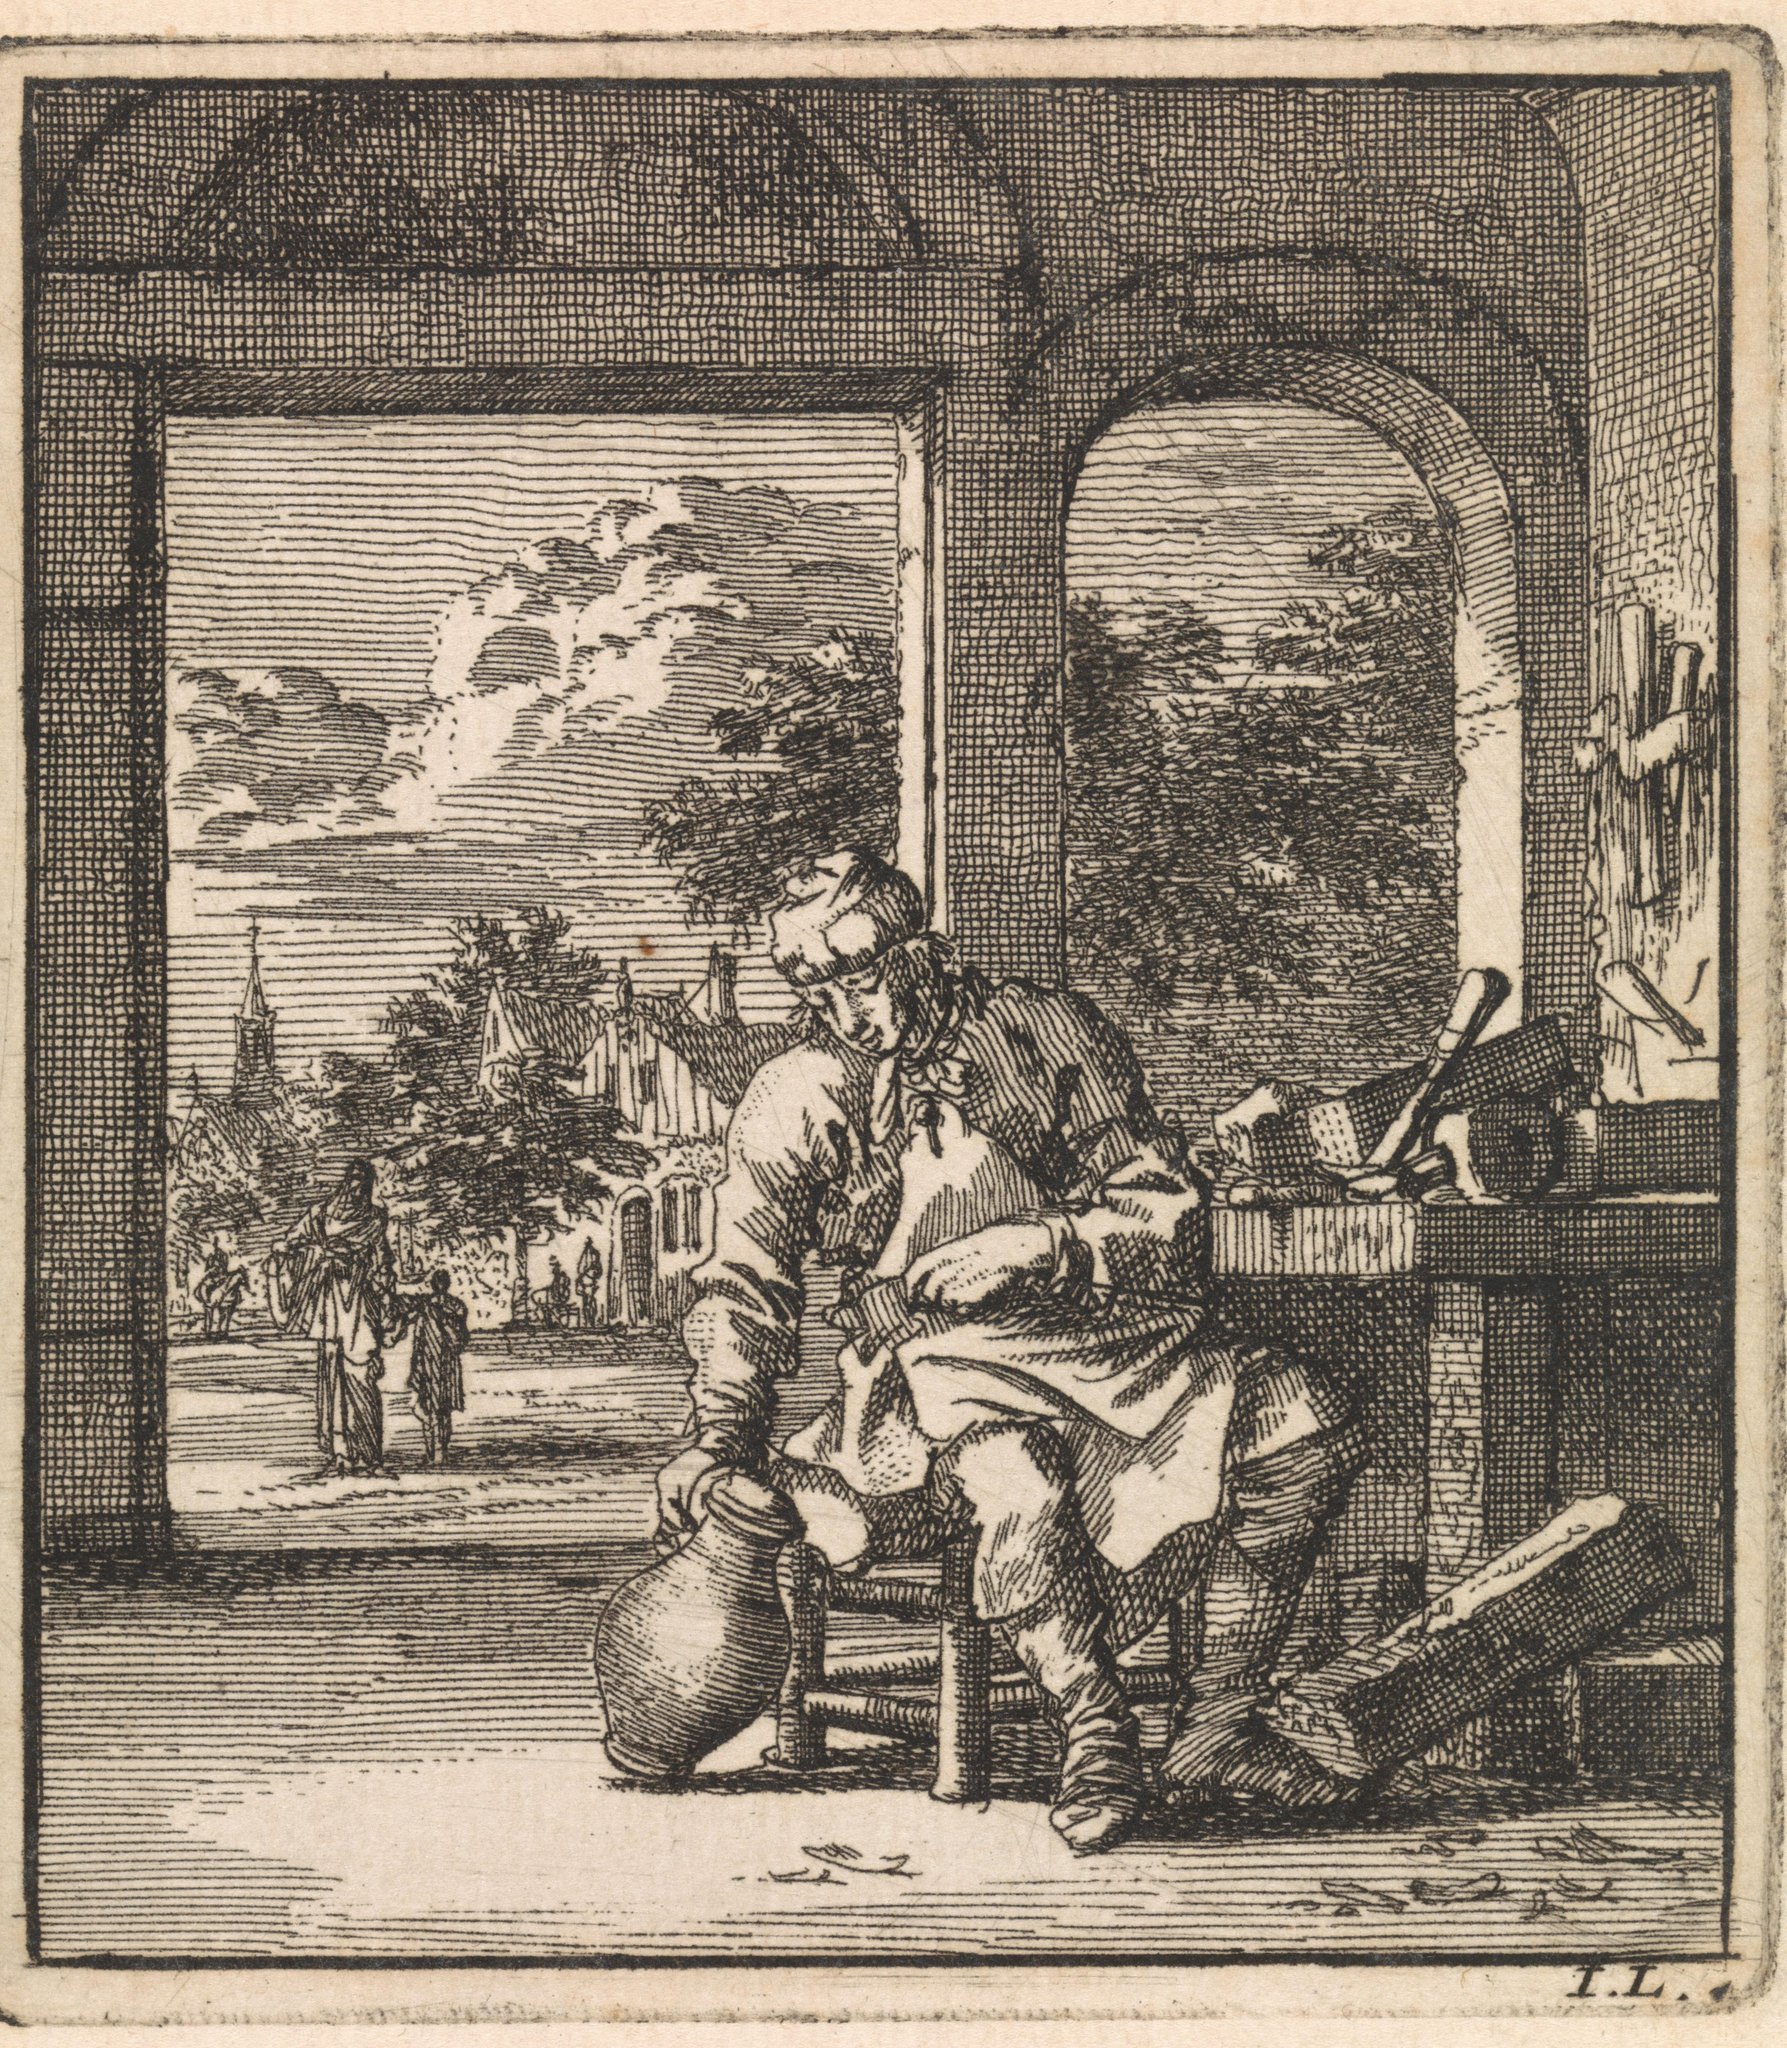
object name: print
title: Naast een schaafbank zit een man met een kan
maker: jan luyken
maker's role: draughtsman, print maker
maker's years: 1649-1712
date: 1711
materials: paper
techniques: etching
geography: amsterdam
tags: smoothing, flattening (industrial process), jar, jug (used as drinking-vessel)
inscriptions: collector's mark: Lugt 2228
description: Illustratie voor: Luyken, Jan. Het leerzaam huisraad, vertoond in vyftig konstige figuuren, met godlyke spreuken en stichtelyke verzen: Pieter Arentsz. II (wed.) en Cornelis van der Sys, 1711, p. 152.